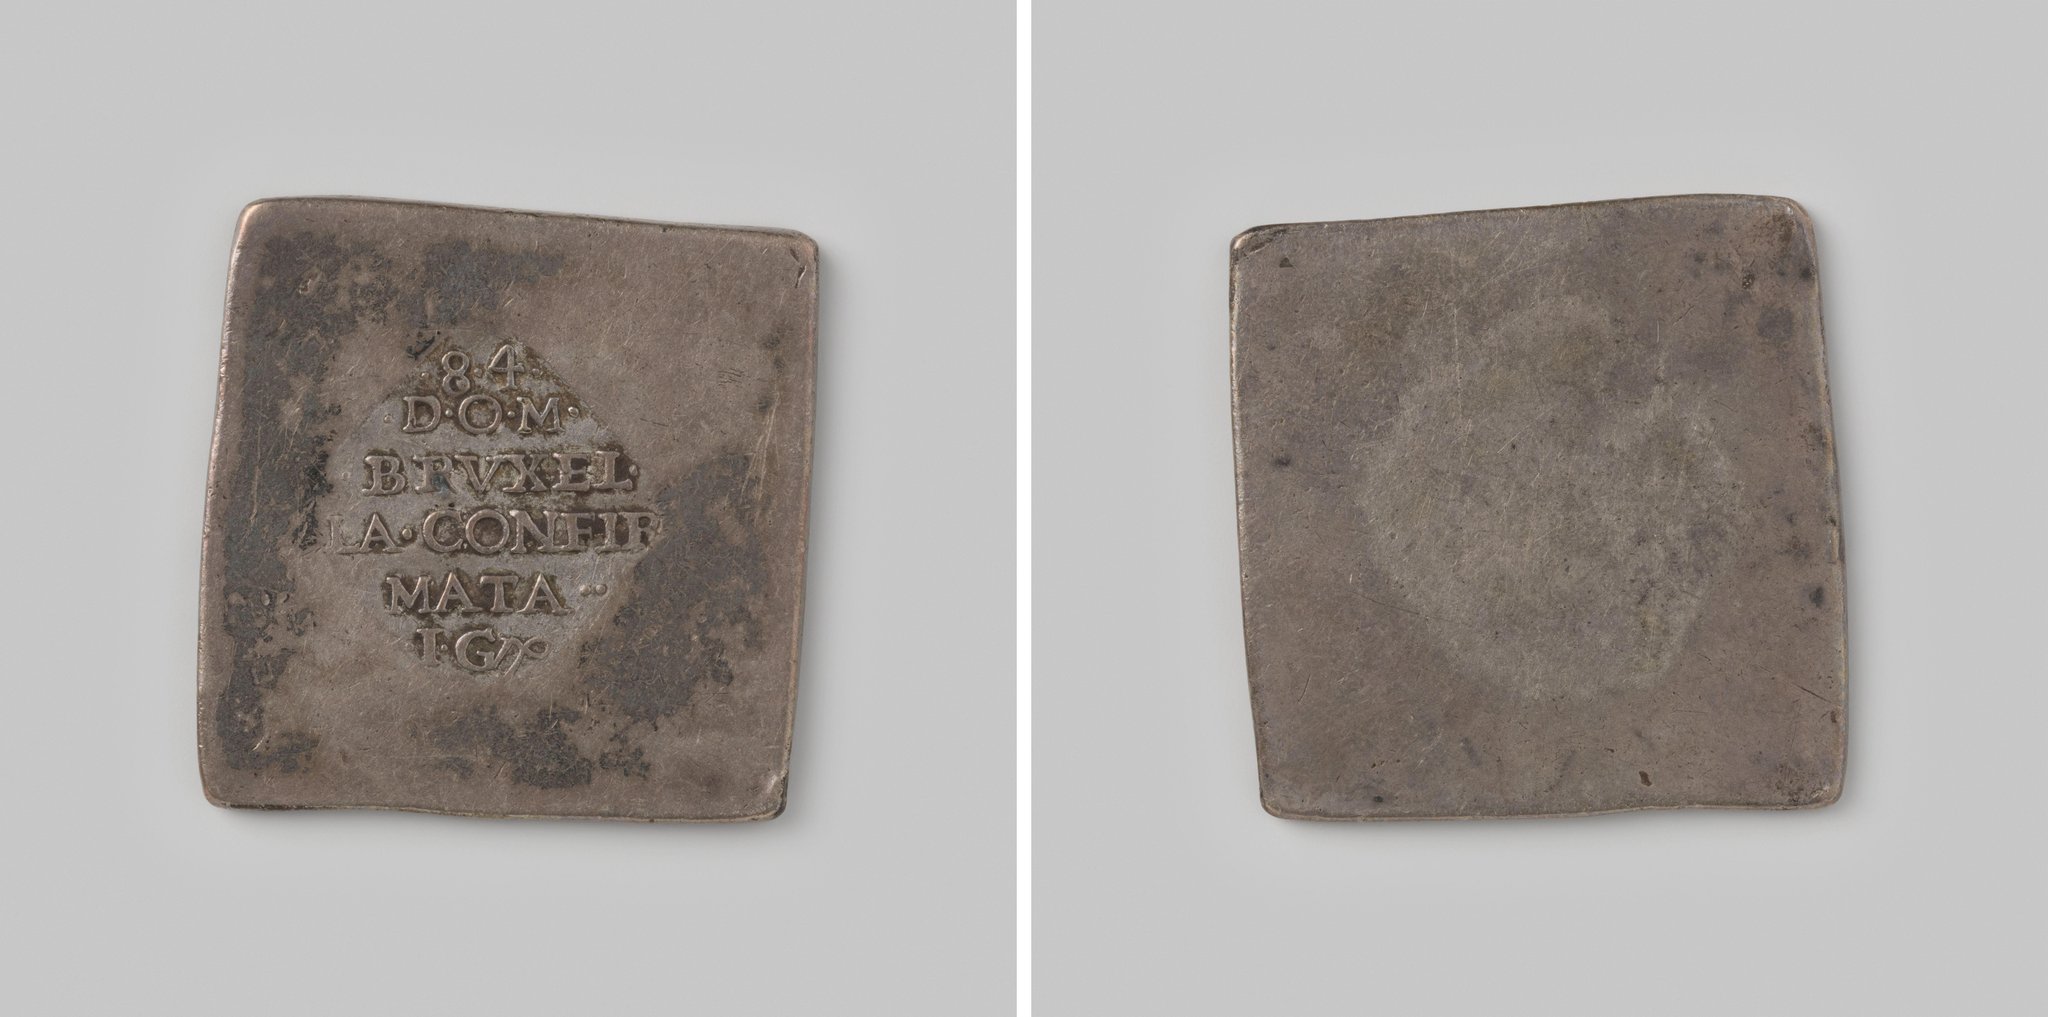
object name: gulden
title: Stad Brussel, noodmunt van 1 gulden, 1584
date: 1584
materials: silver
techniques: striking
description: Zilveren vierkante noodmunt. Voorzijde: vierregelig opschrift, waarboven jaartal: .8.4. [=1584] en waaronder waarde-aanduiding: 1 Gl. Keerzijde: glad.